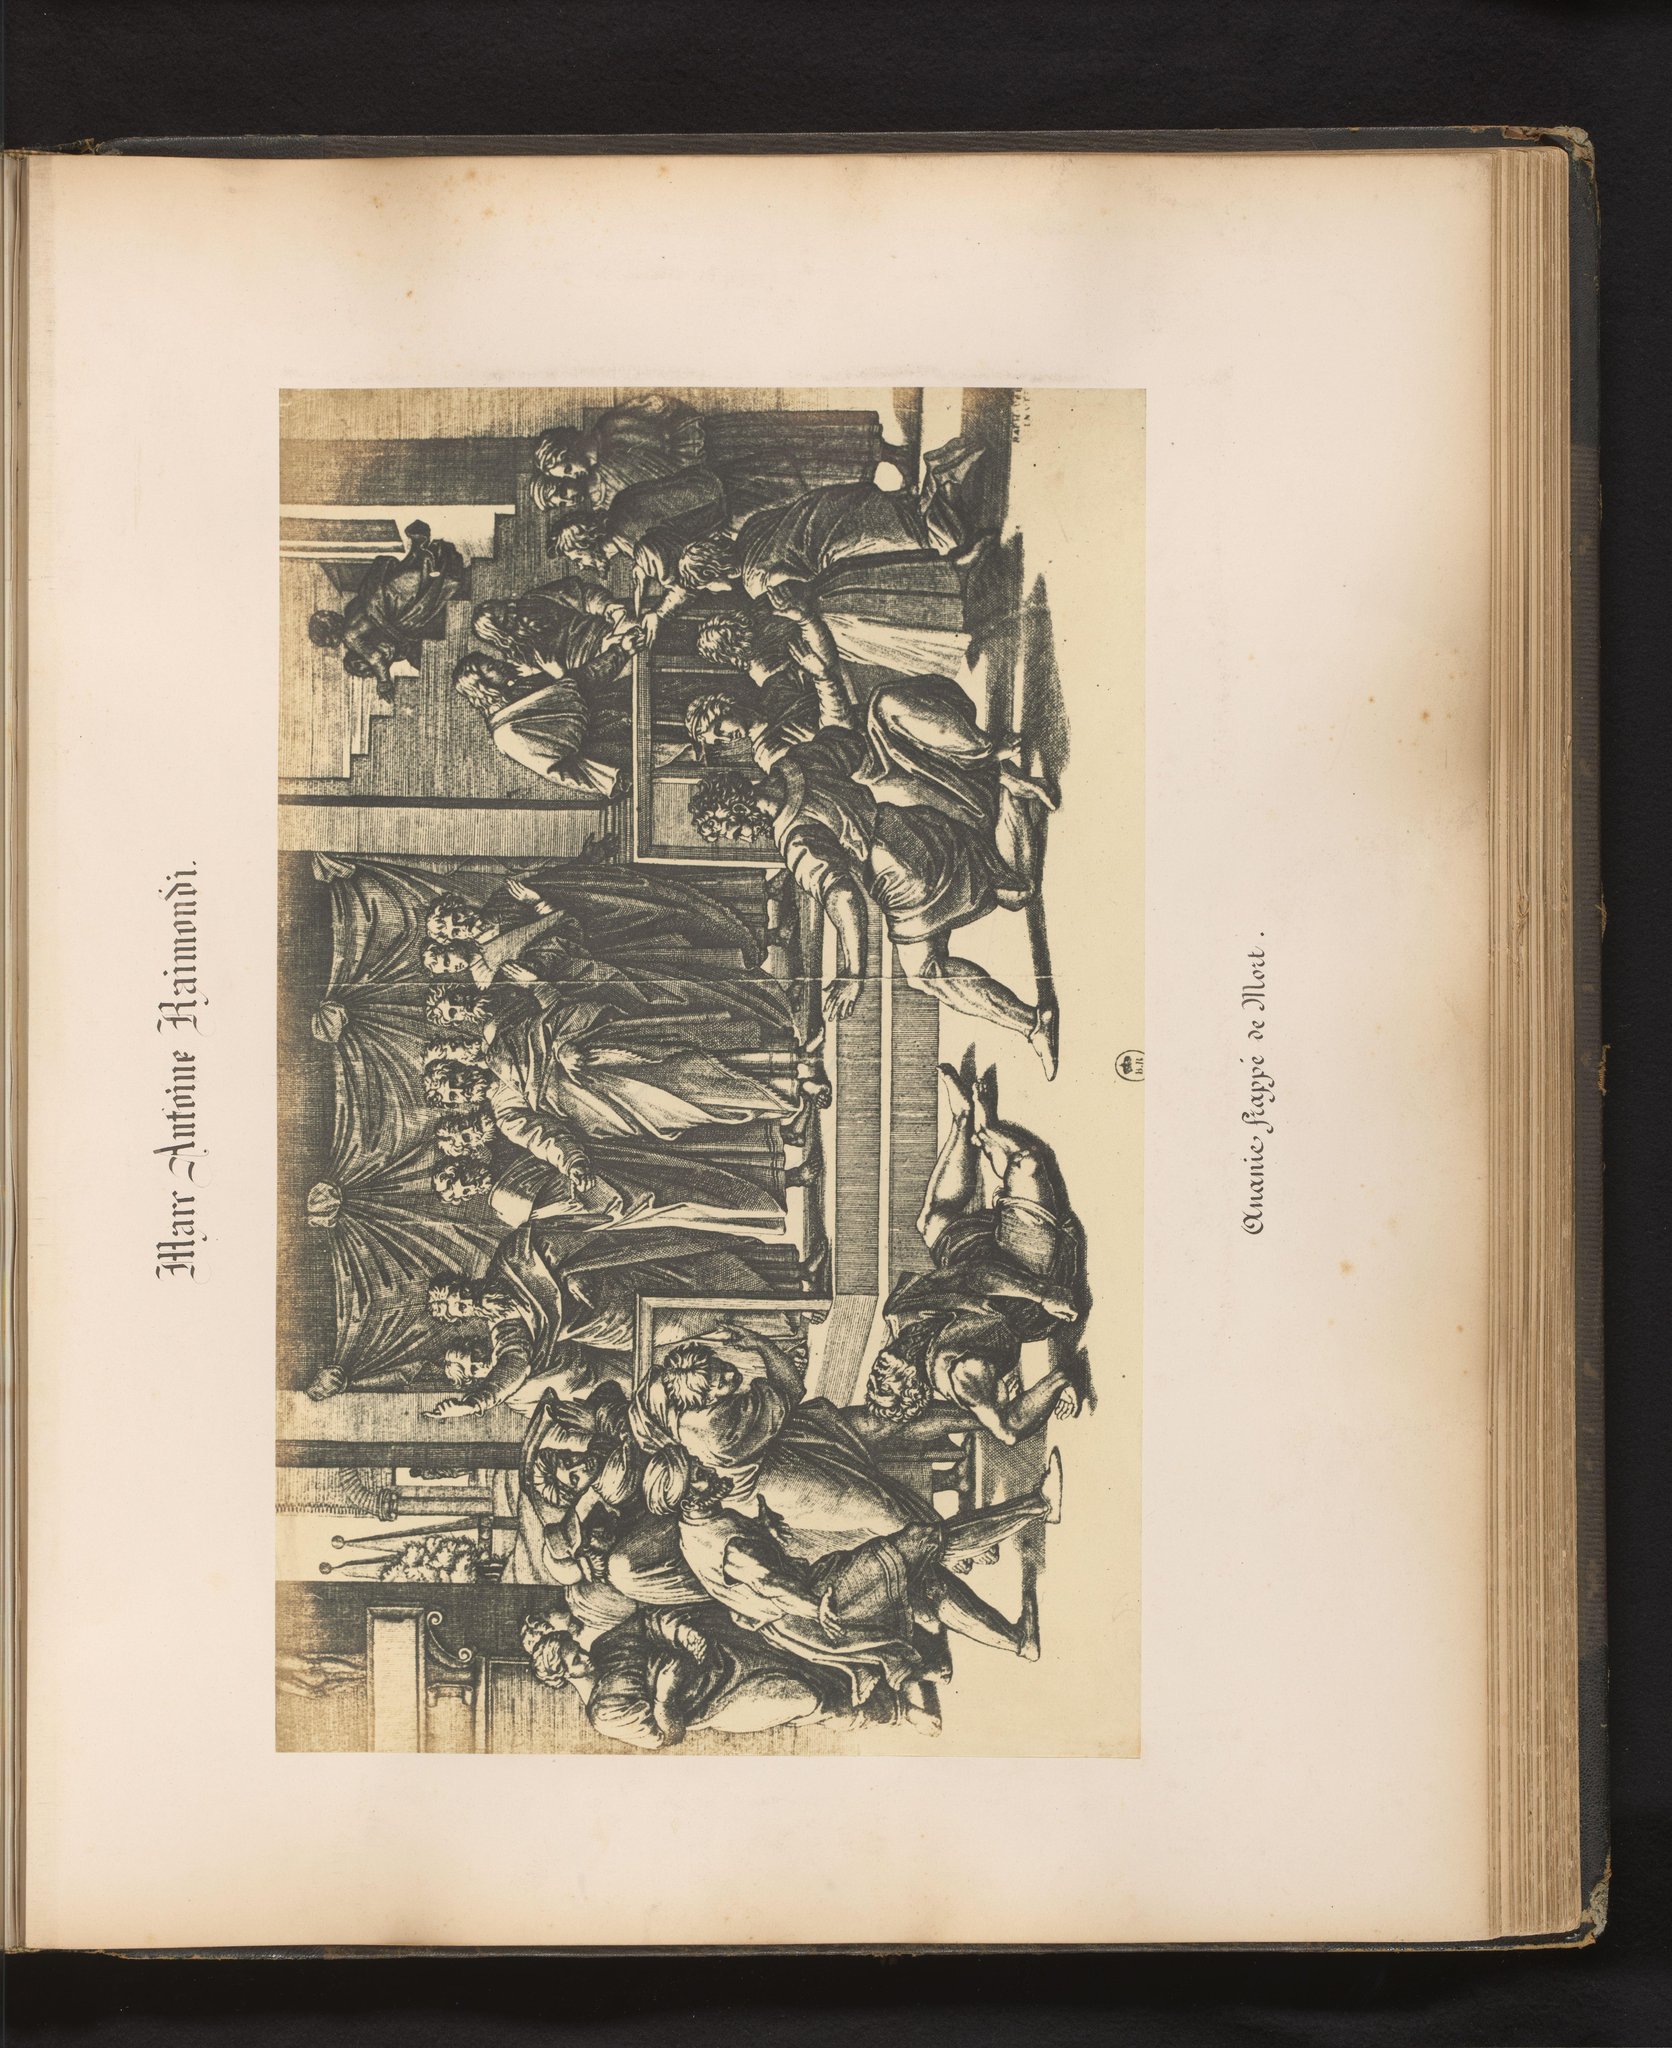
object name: reproduction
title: Ananie frappé de Mort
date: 1848-1853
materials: photographic support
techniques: salted paper print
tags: ananias, rebuked by peter, falls down and dies between his gifts